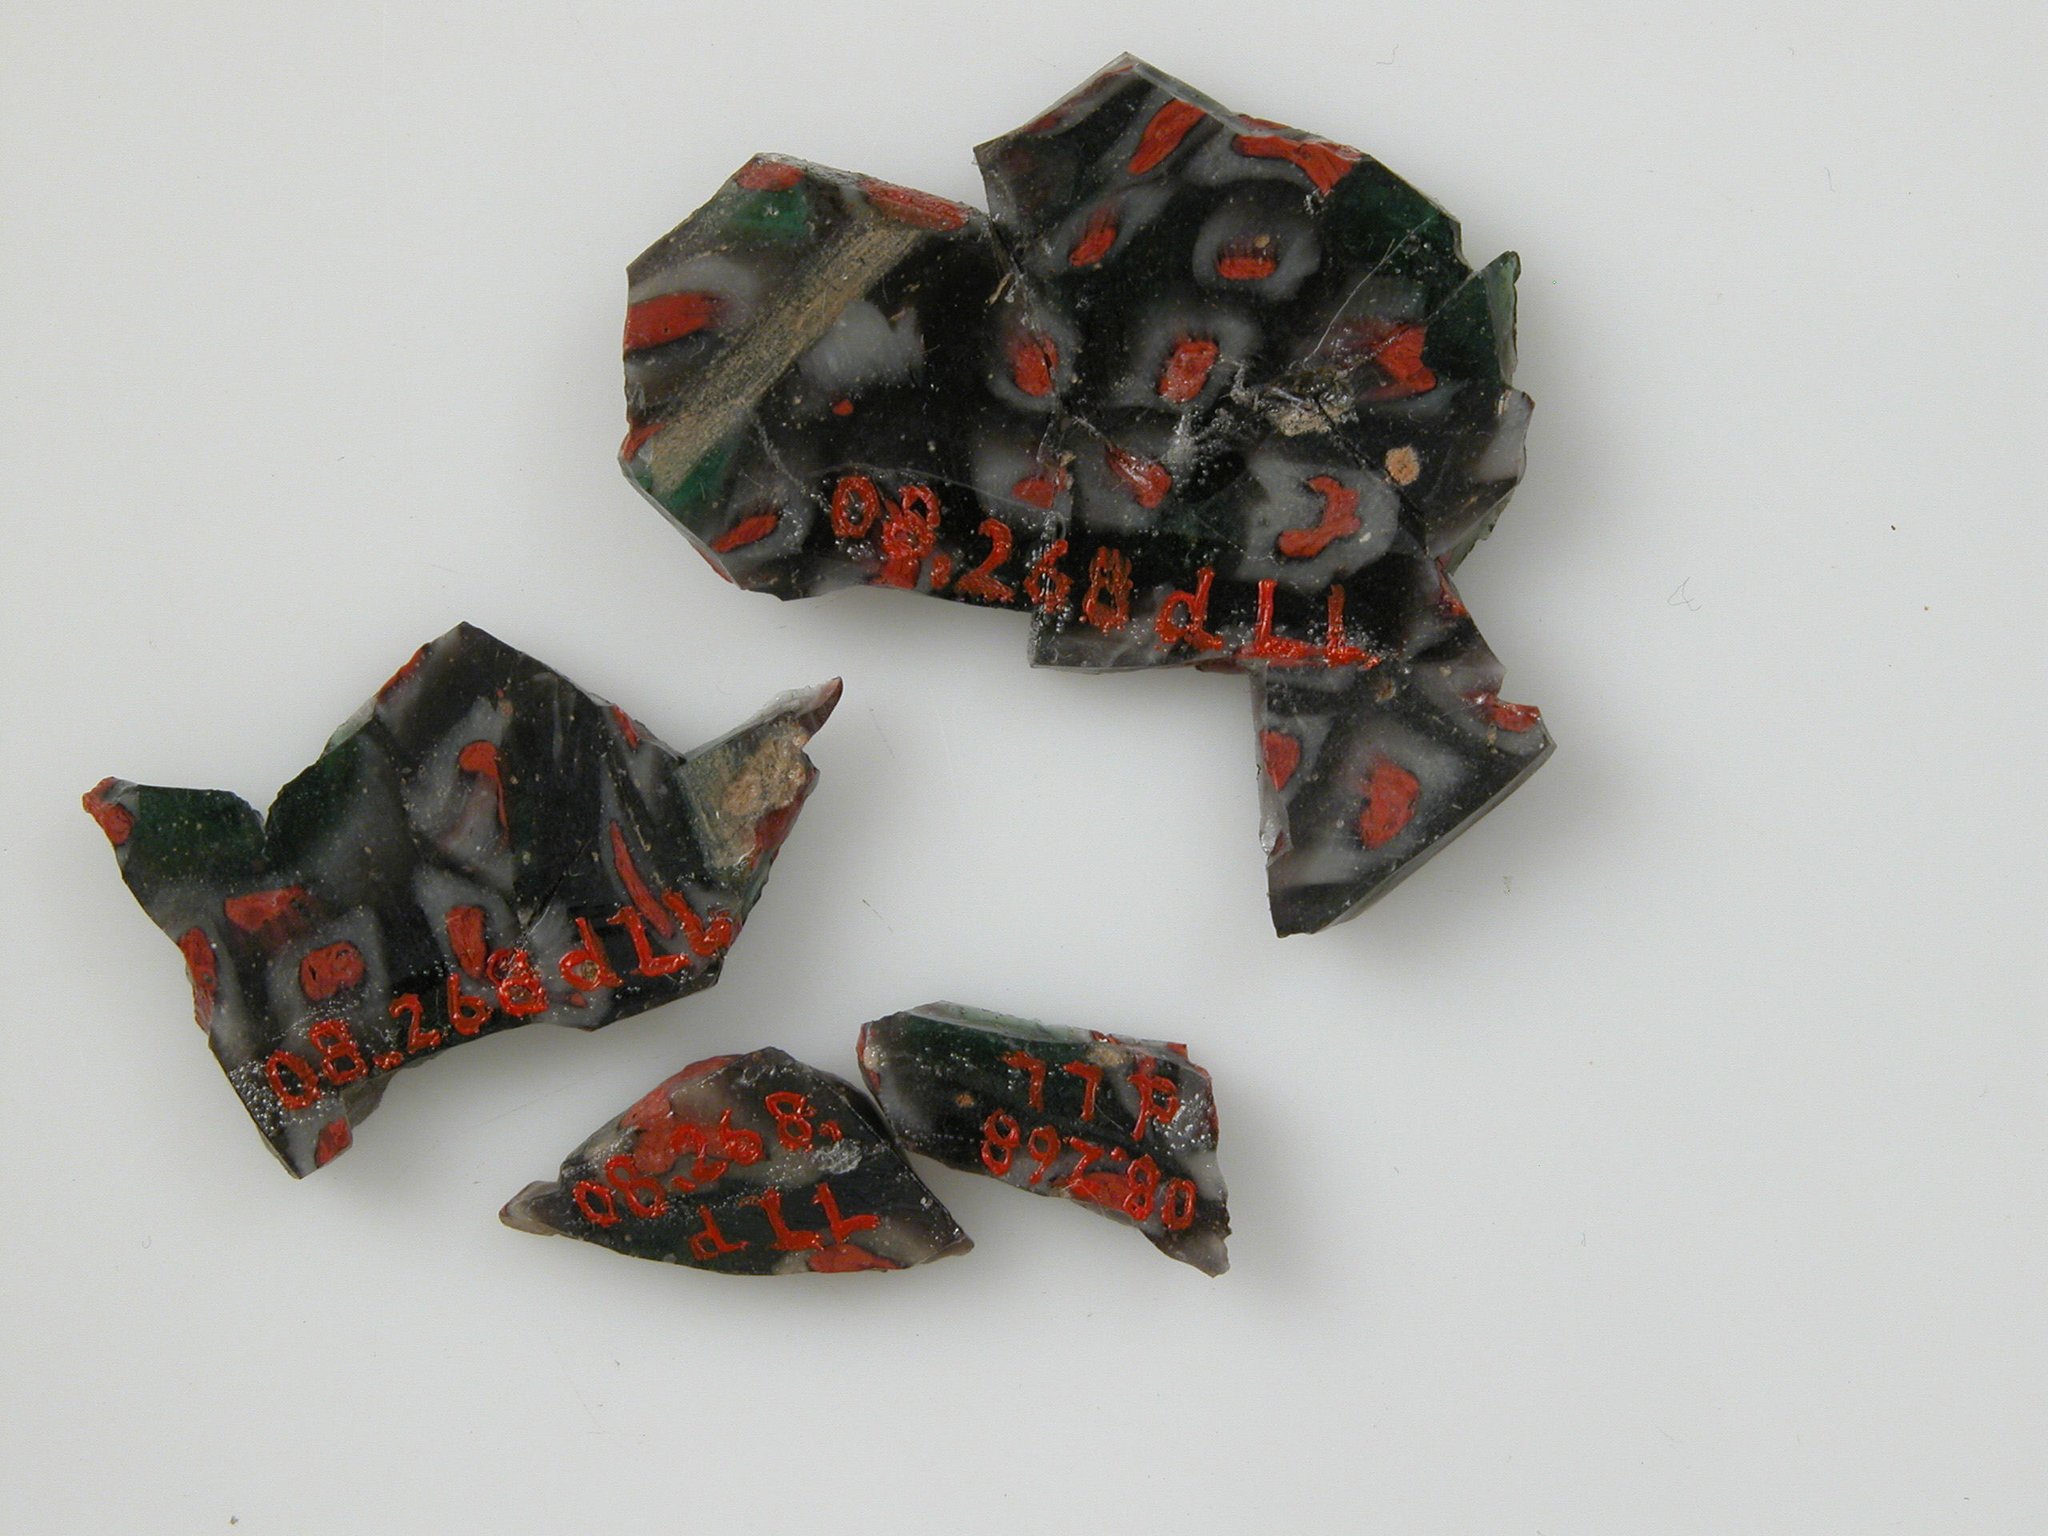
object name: fragment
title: Glass Fragments from a Vessel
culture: coptic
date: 301-433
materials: glass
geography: egypt